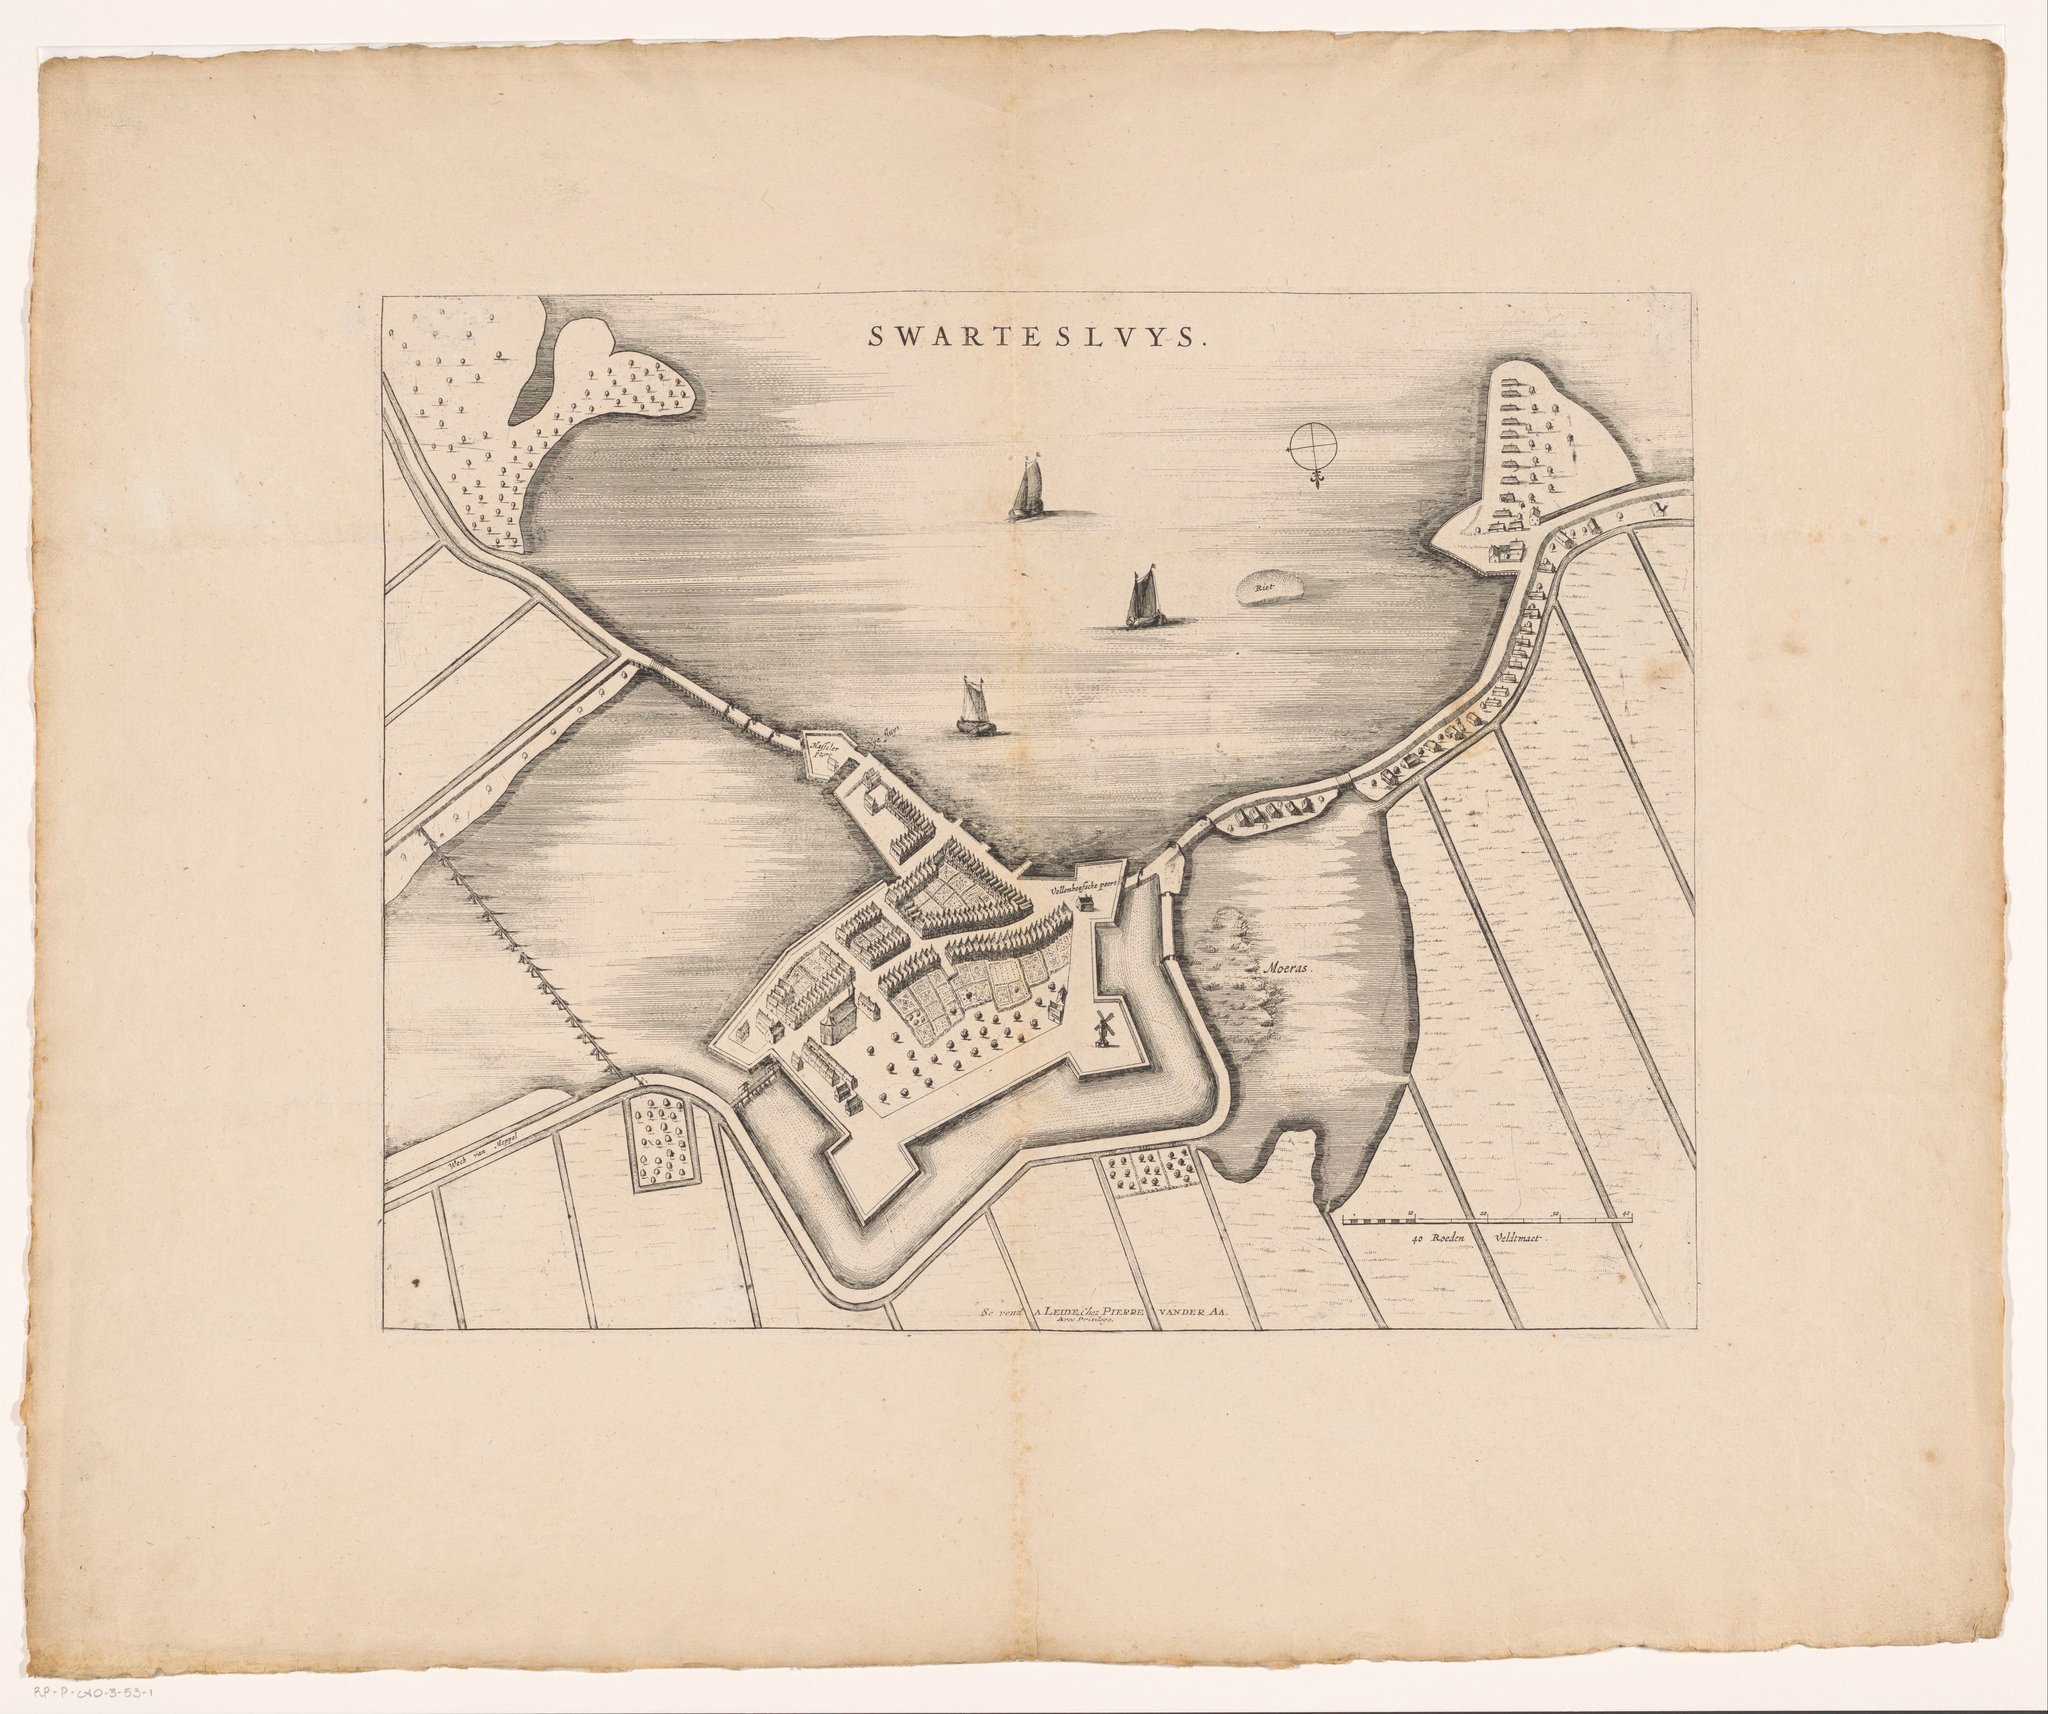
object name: print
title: Plattegrond van Zwartsluis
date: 1649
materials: paper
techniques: engraving, etching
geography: leiden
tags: maps of cities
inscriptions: collector's mark: Lugt 19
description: Prent ook gebruikt in: Aa, Pieter van der. La galerie agreable du monde (...). 66 delen. Leiden: Pieter van der Aa, 1728, dl. 24.